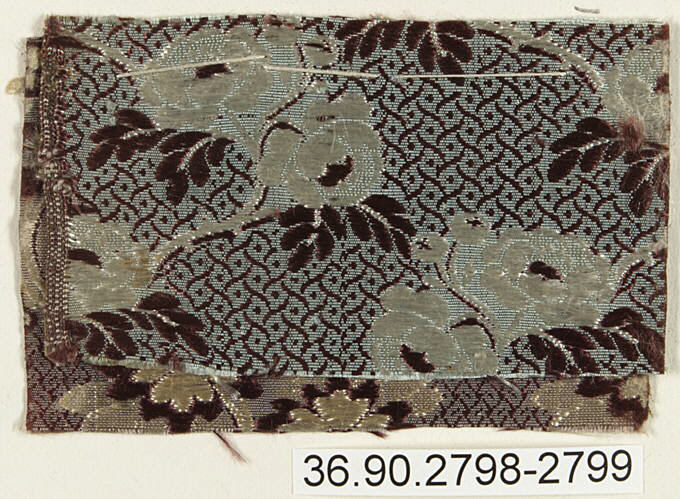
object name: piece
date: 1801-1900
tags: flowers,leaves